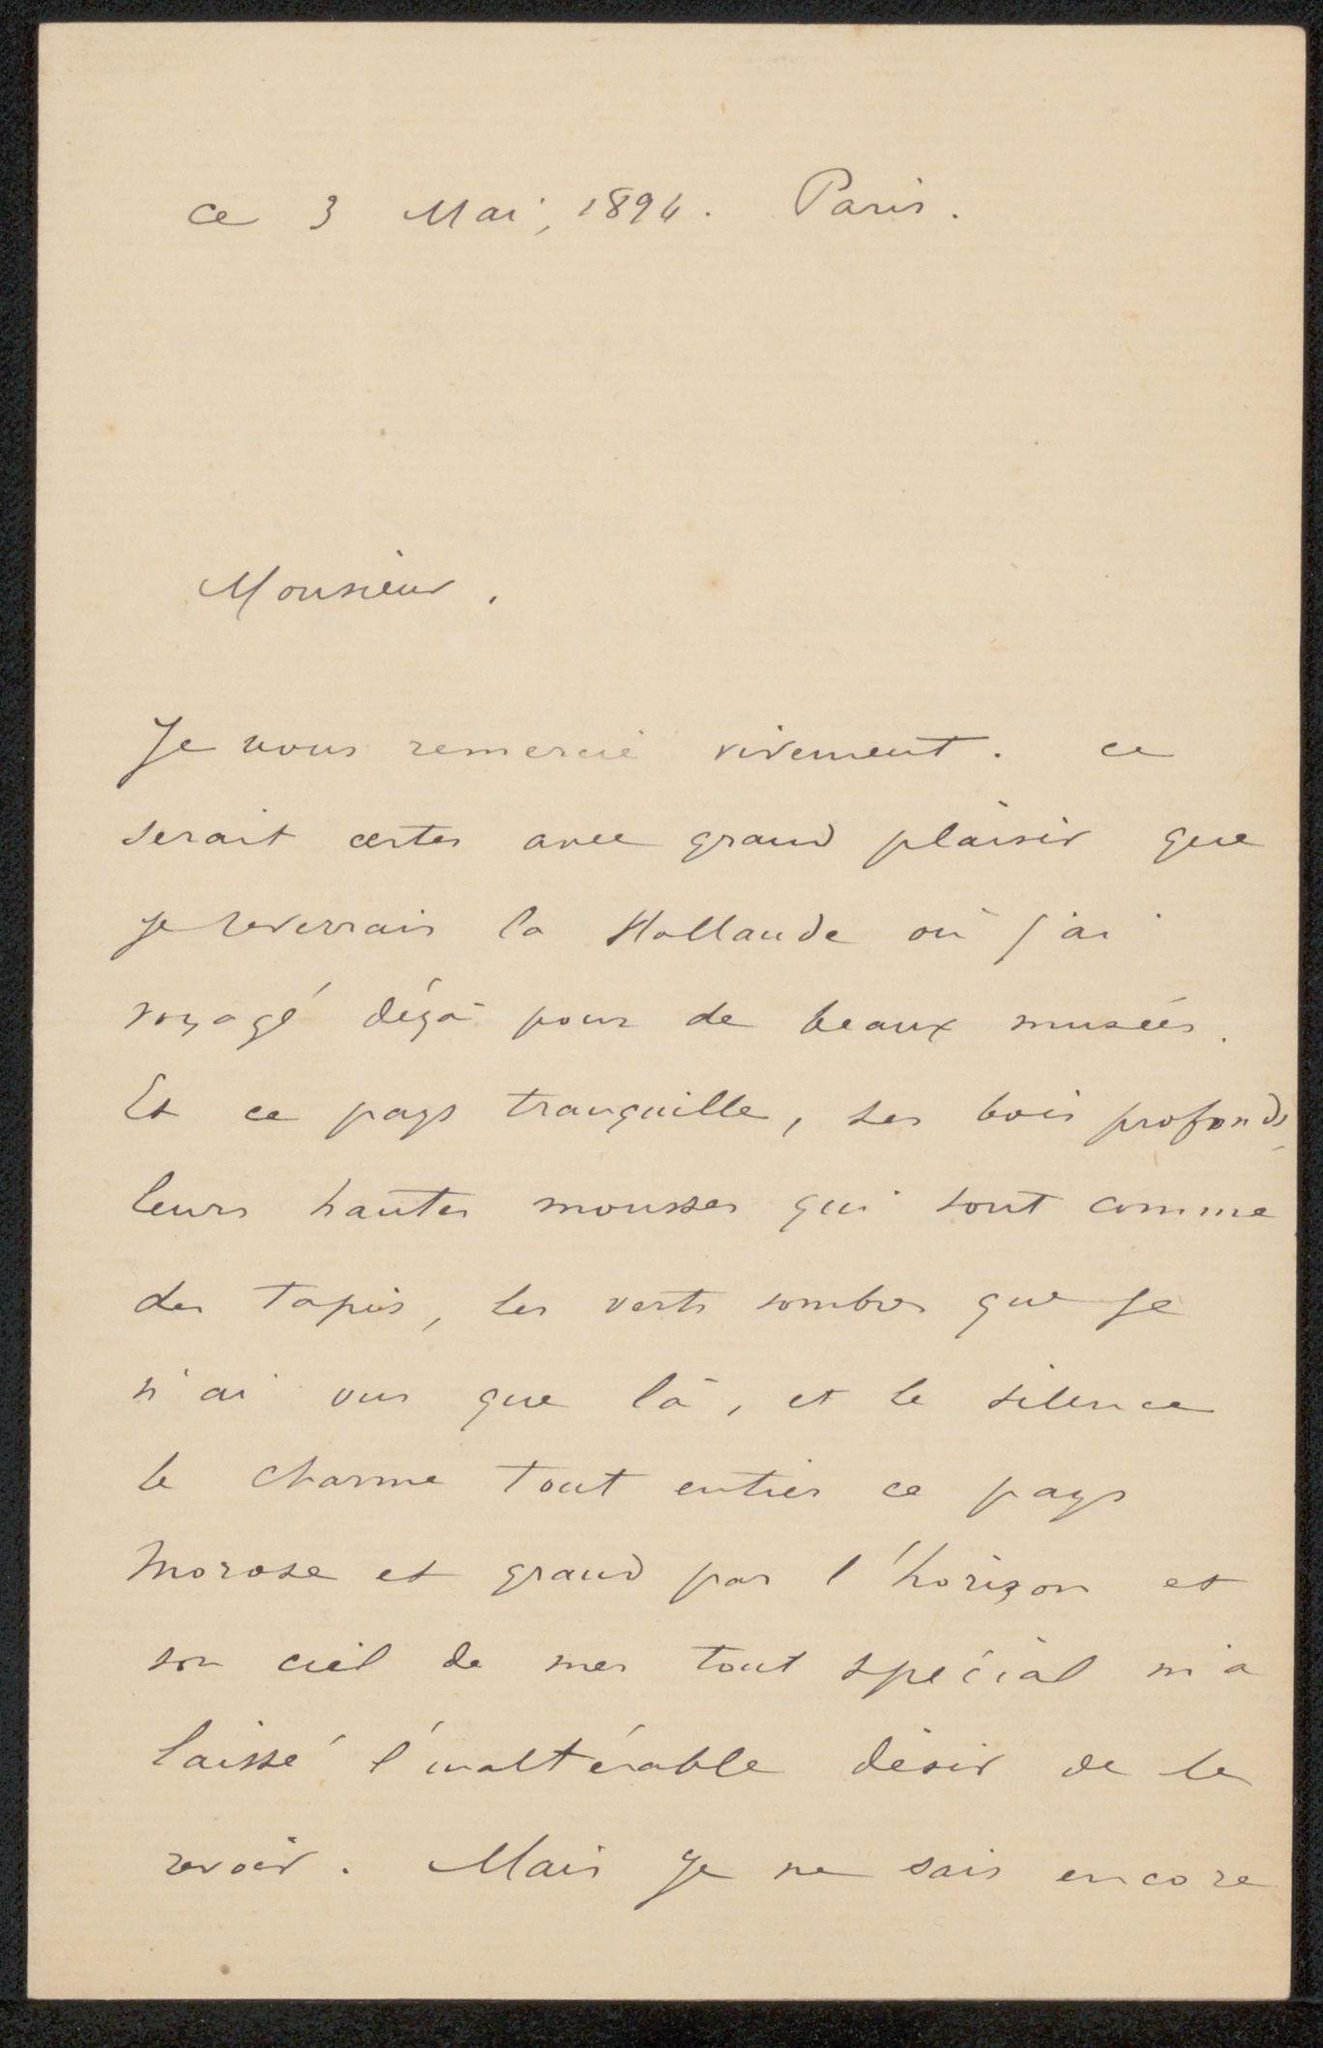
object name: letter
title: Brief aan Philip Zilcken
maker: odilon redon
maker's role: draughtsman, painter, print maker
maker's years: 1840-1916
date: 1894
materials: ink, paper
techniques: pen, writing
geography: paris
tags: arnhem, anacapri, sculptor, saar de swart, the hague, painter, philip zilcken, netherlands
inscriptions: collector's mark: ‘RPK’, watermark